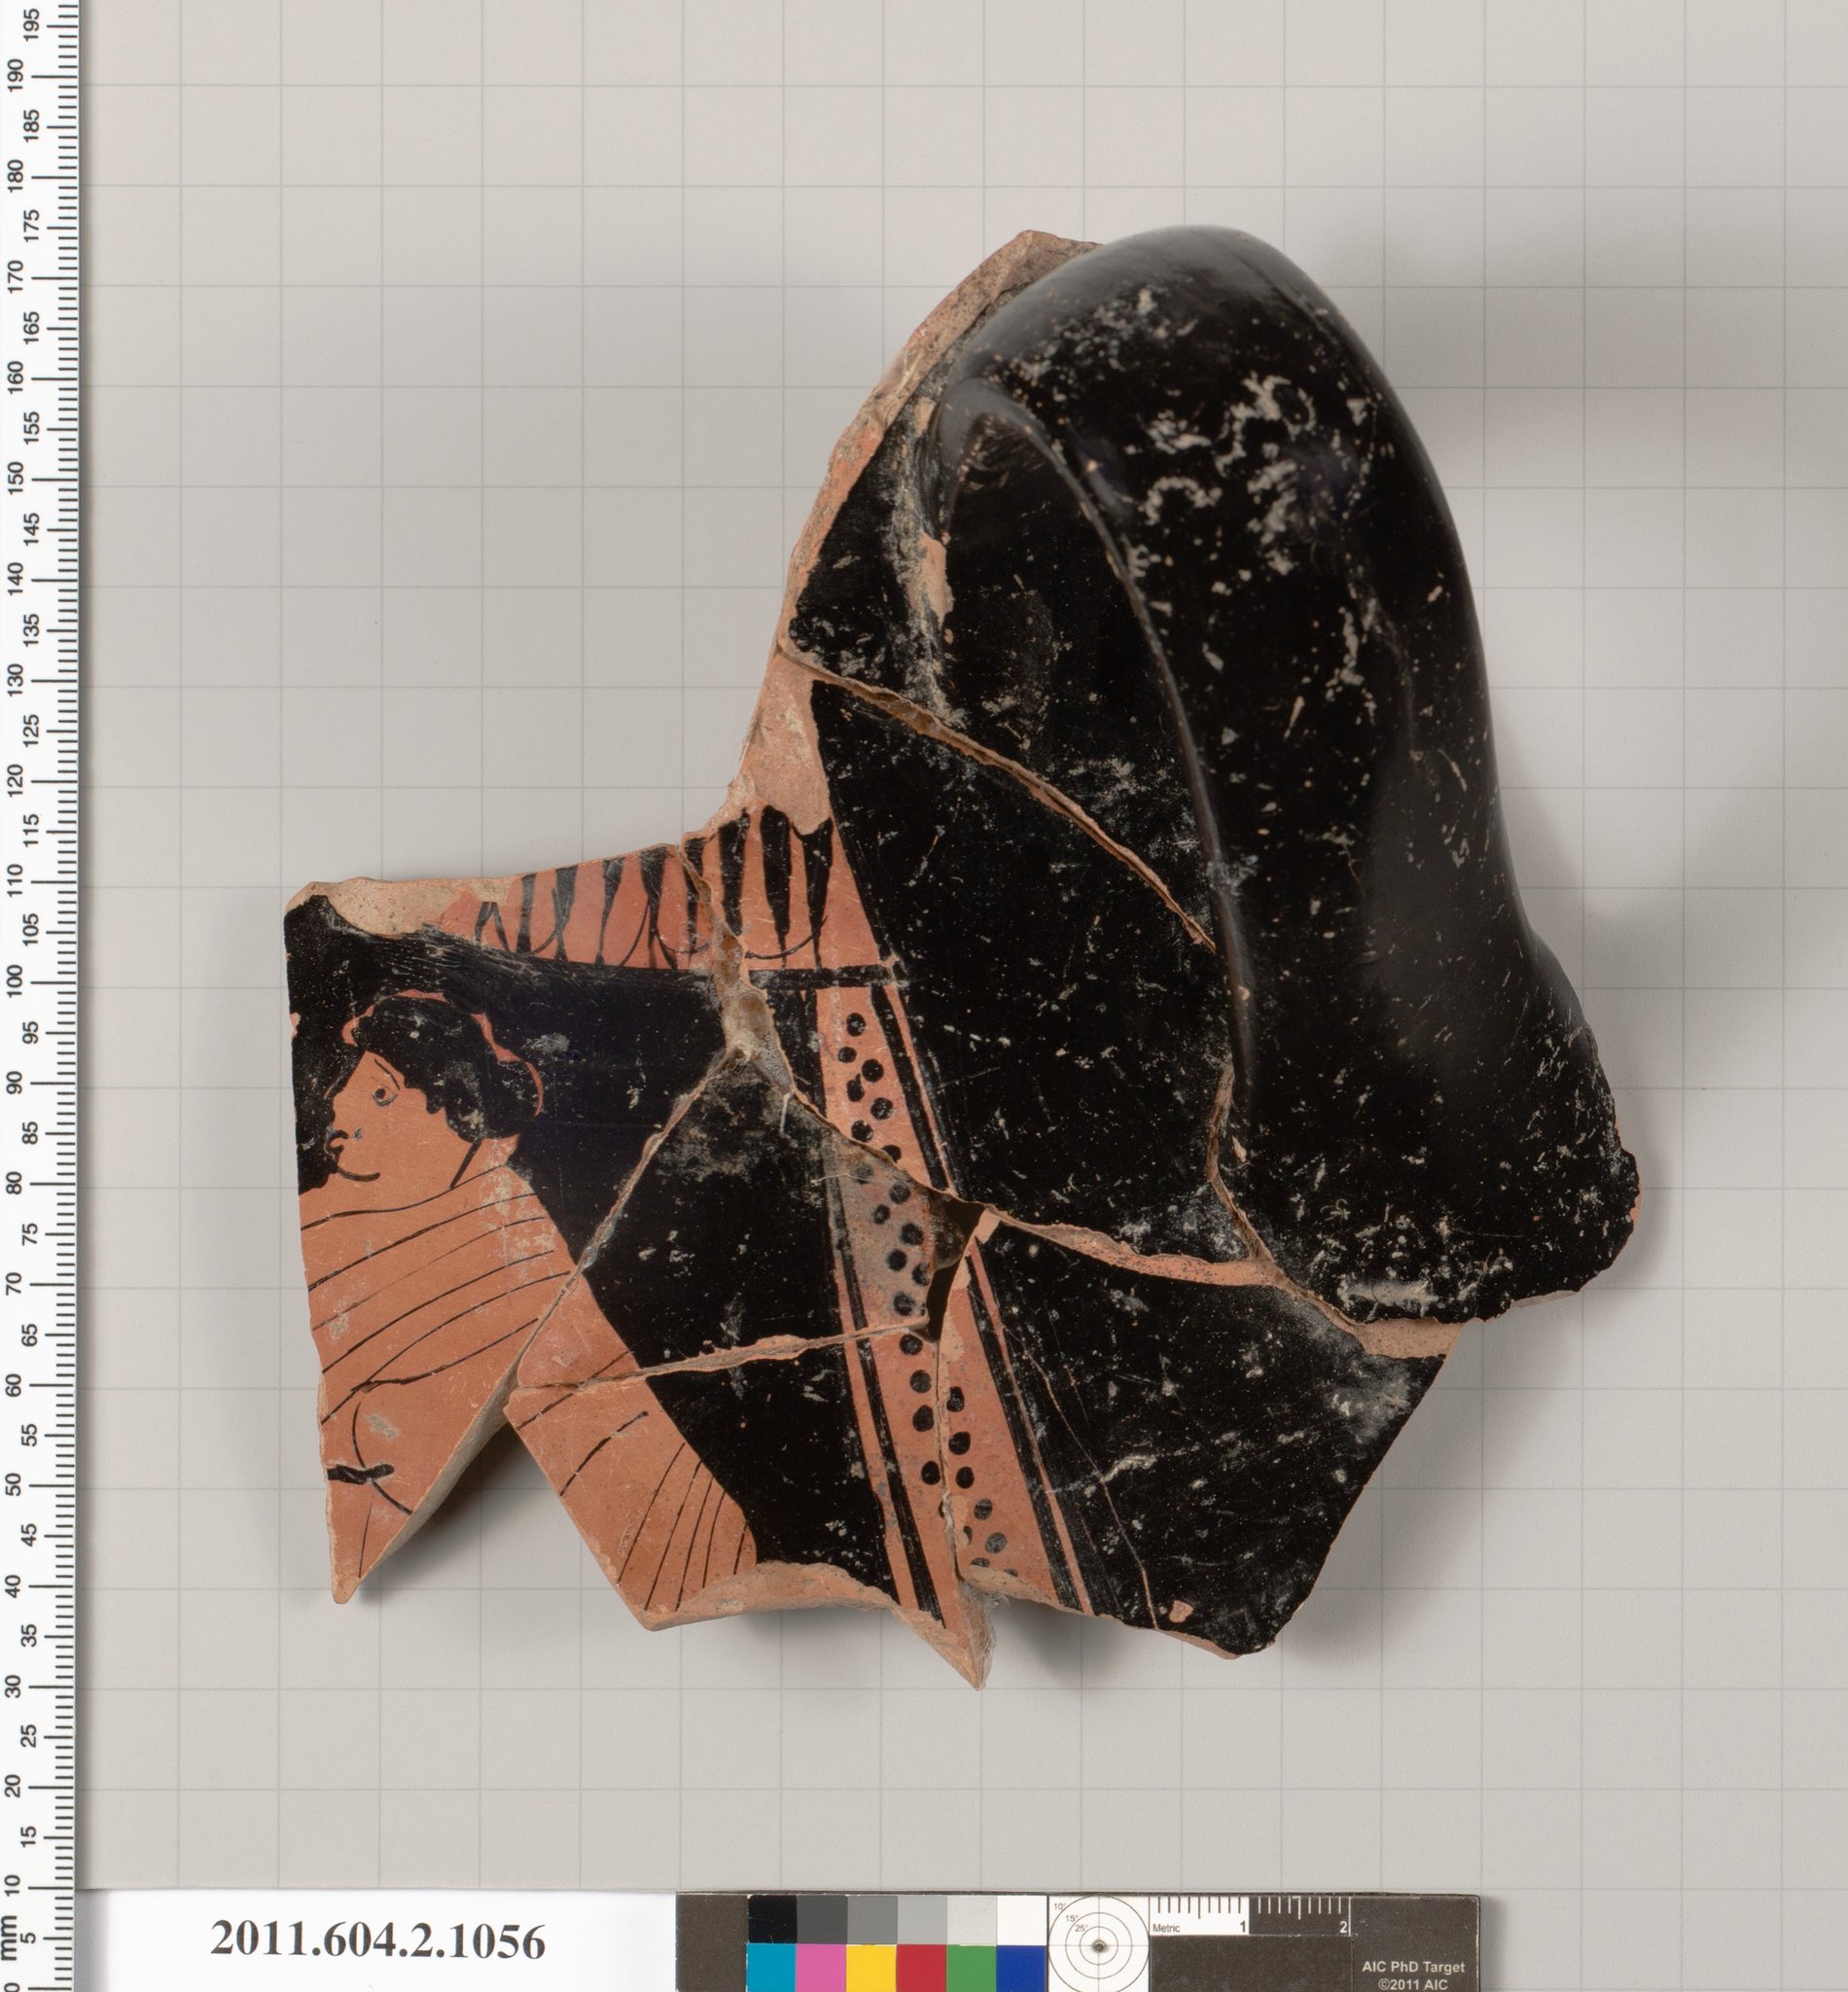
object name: pelike fragment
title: Terracotta fragment of a pelike (jar)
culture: greek, attic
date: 450-426 BCE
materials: terracotta